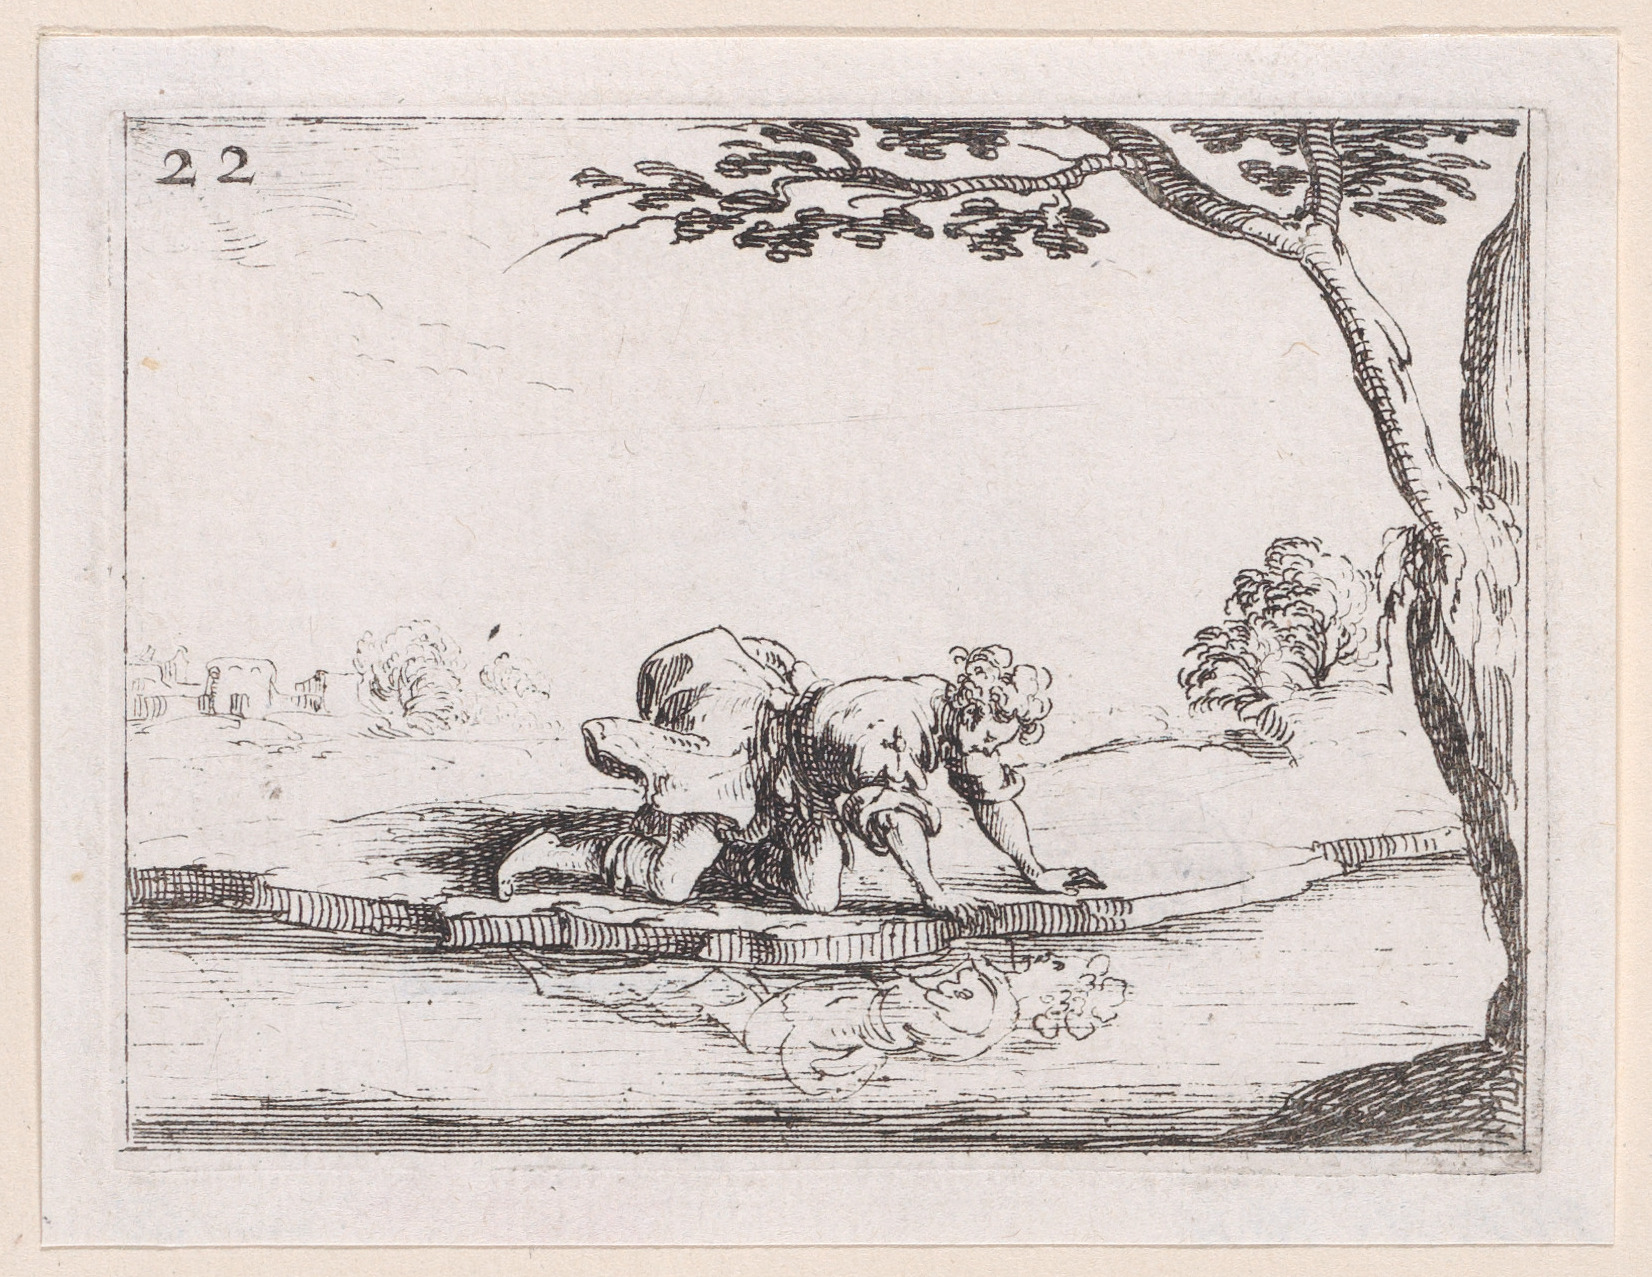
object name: print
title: Narcisse se Mirant dans l'Eau (Narcissus Looking at Himself in the Water), plate 22 from "Lux Claustri ou La Lumière du Cloitre" (The Light of the Cloisters)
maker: jacques callot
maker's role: artist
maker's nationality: french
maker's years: 1592-1635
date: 1621-1635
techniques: etching